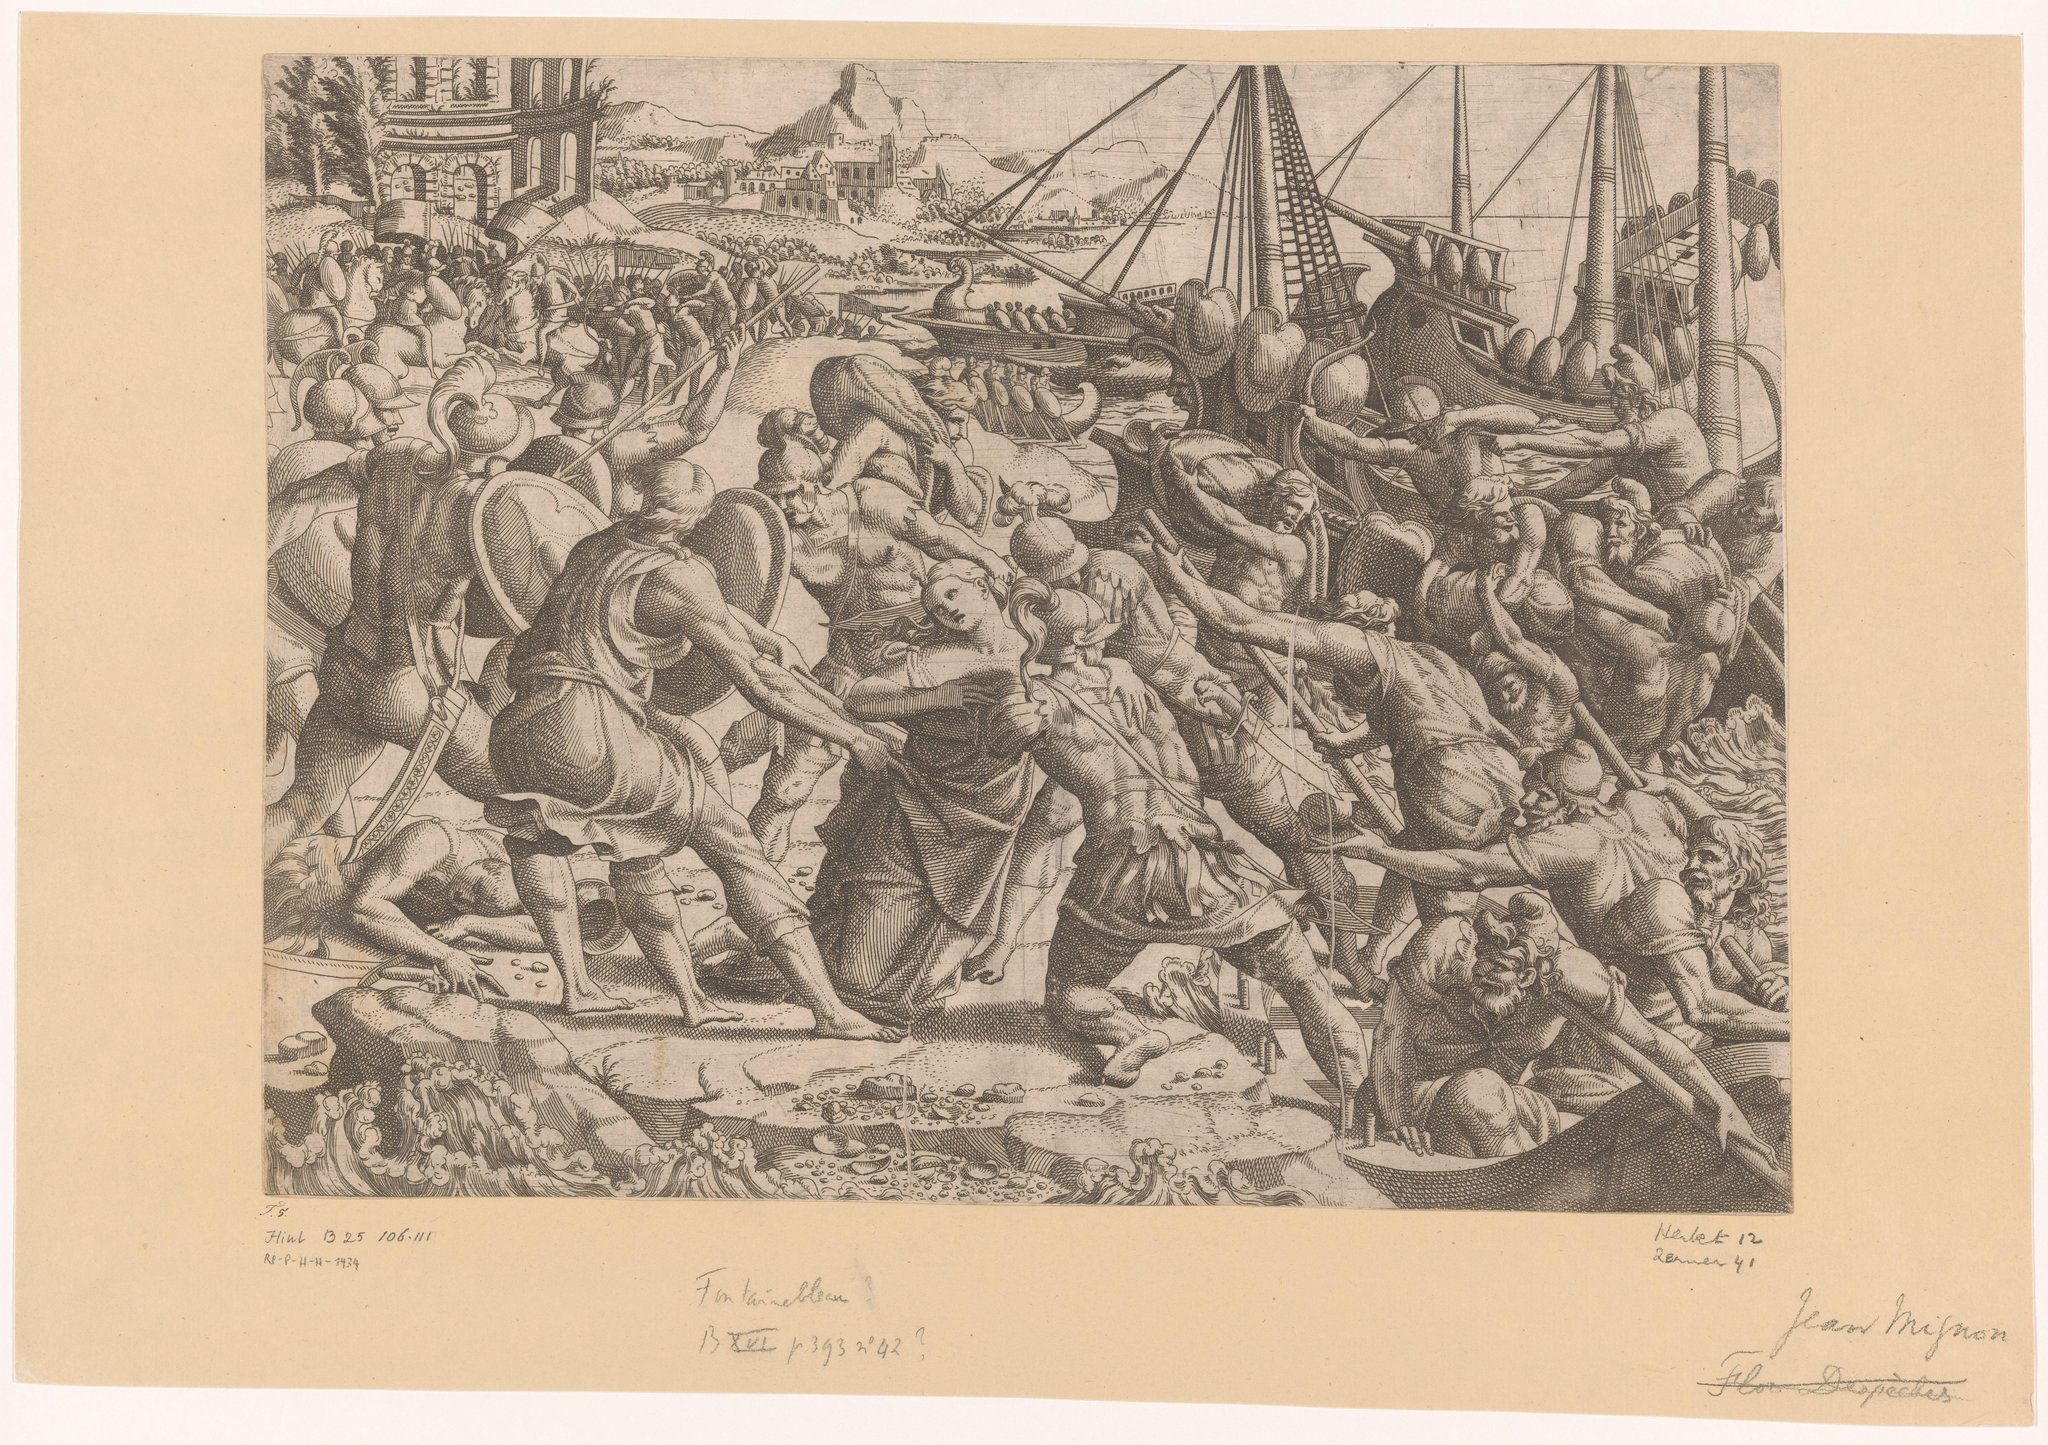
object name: print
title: Geschiedenis van de Trojaanse oorlog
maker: jean mignon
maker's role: print maker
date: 1543-1545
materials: paper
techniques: etching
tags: the abduction of helen and some of her companions: paris carries them off by sea, and takes a part of the palace-treasure with him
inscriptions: collector's mark: Lugt 10